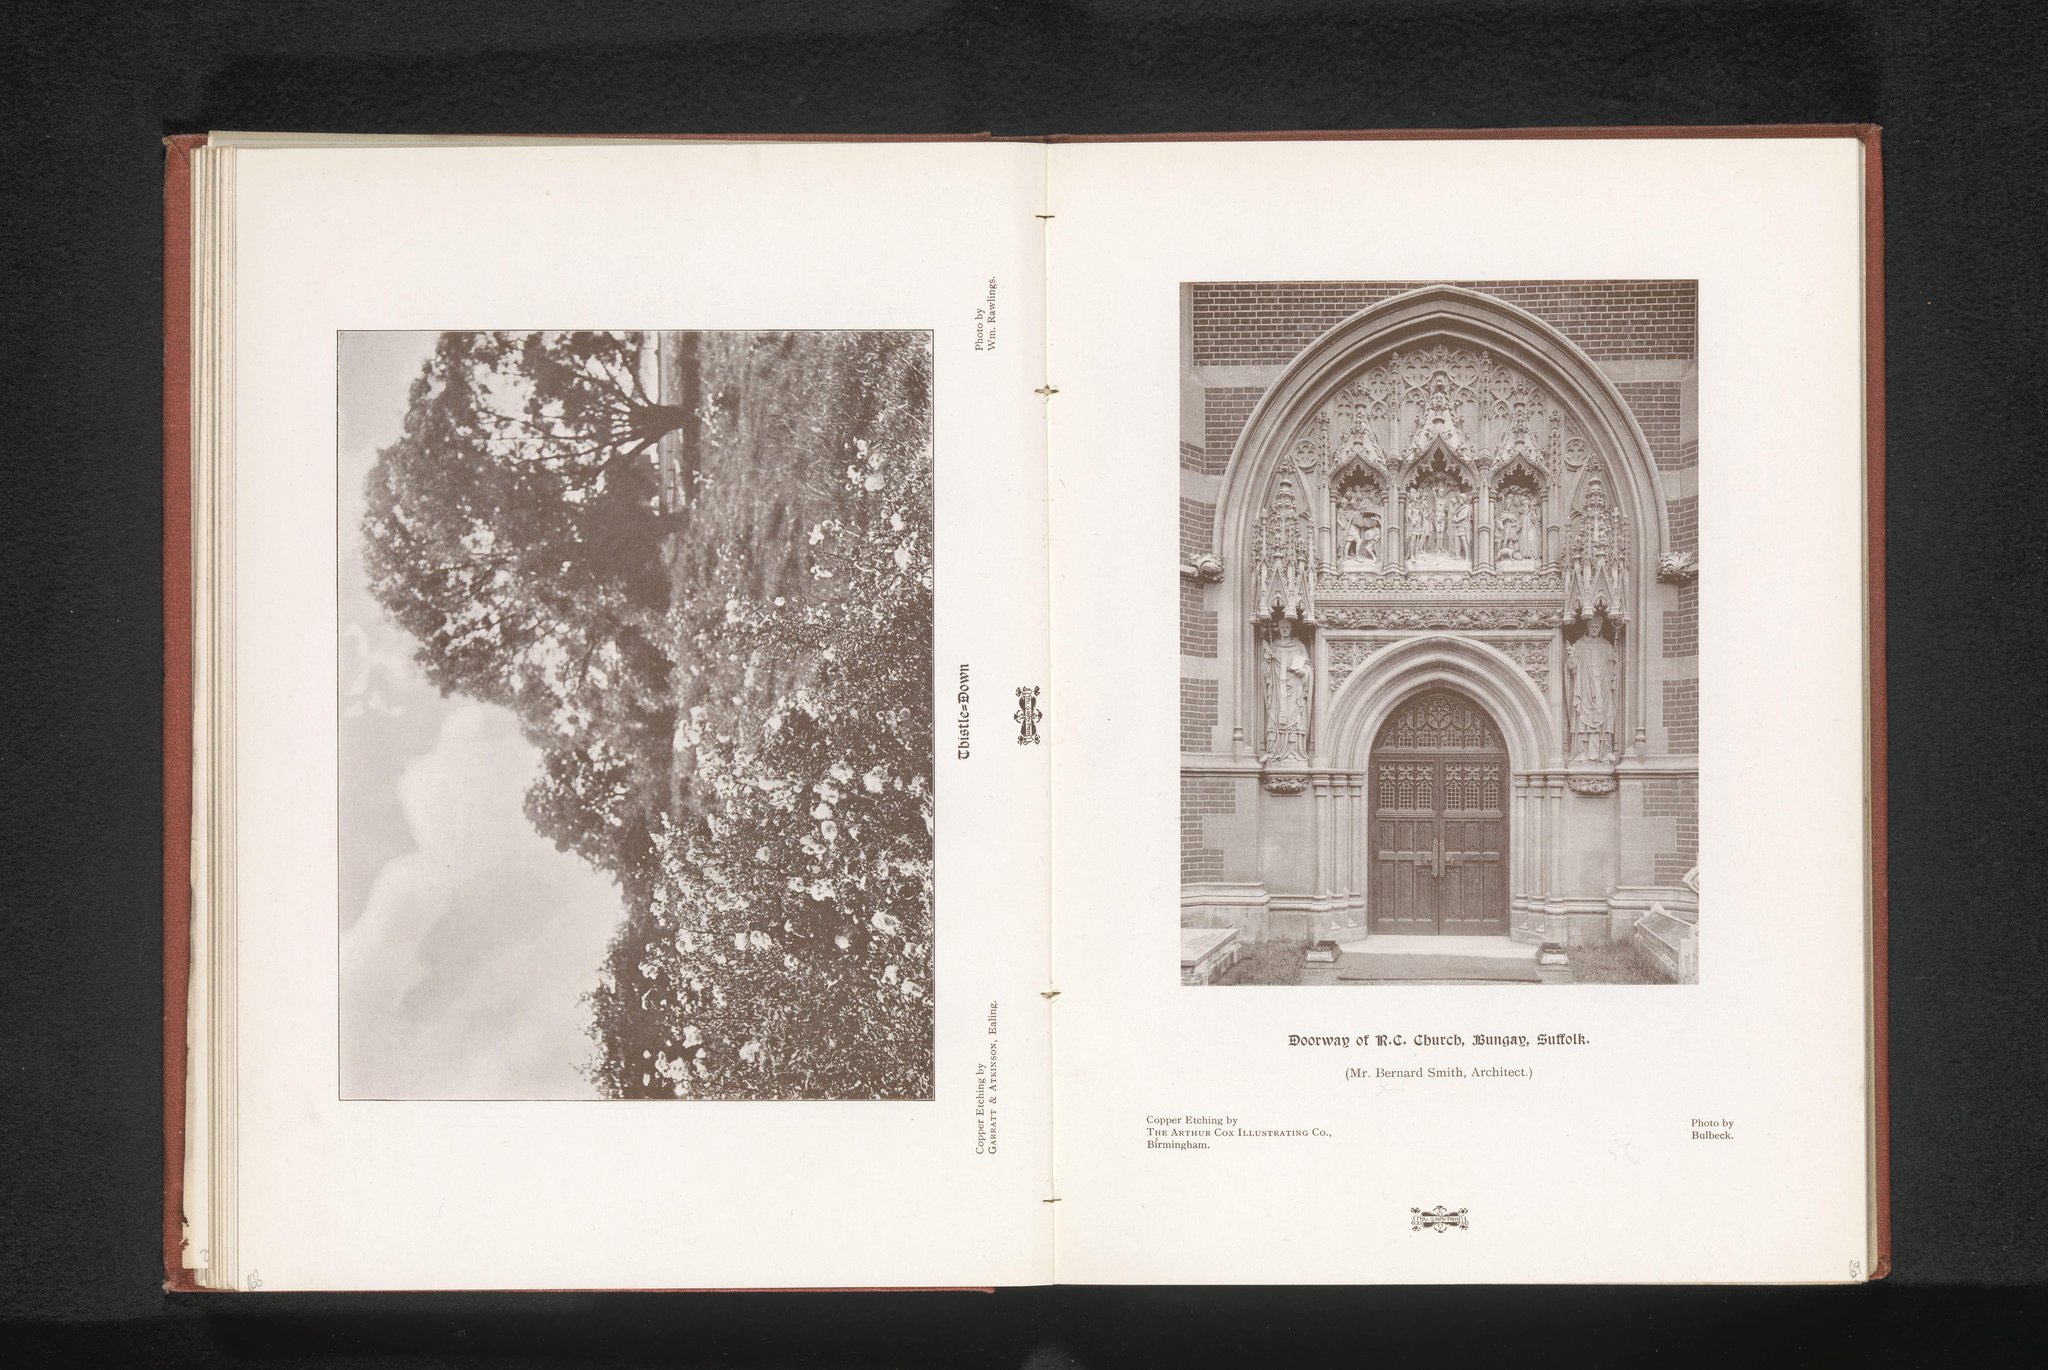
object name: page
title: Portaal van de St. Edmund's Catholic Church te Bungay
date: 1895-1900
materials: paper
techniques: autotype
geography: bungay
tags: parts of church exterior and annexes: portal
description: Prent op elfde ongenummerde pagina na pagina 52.